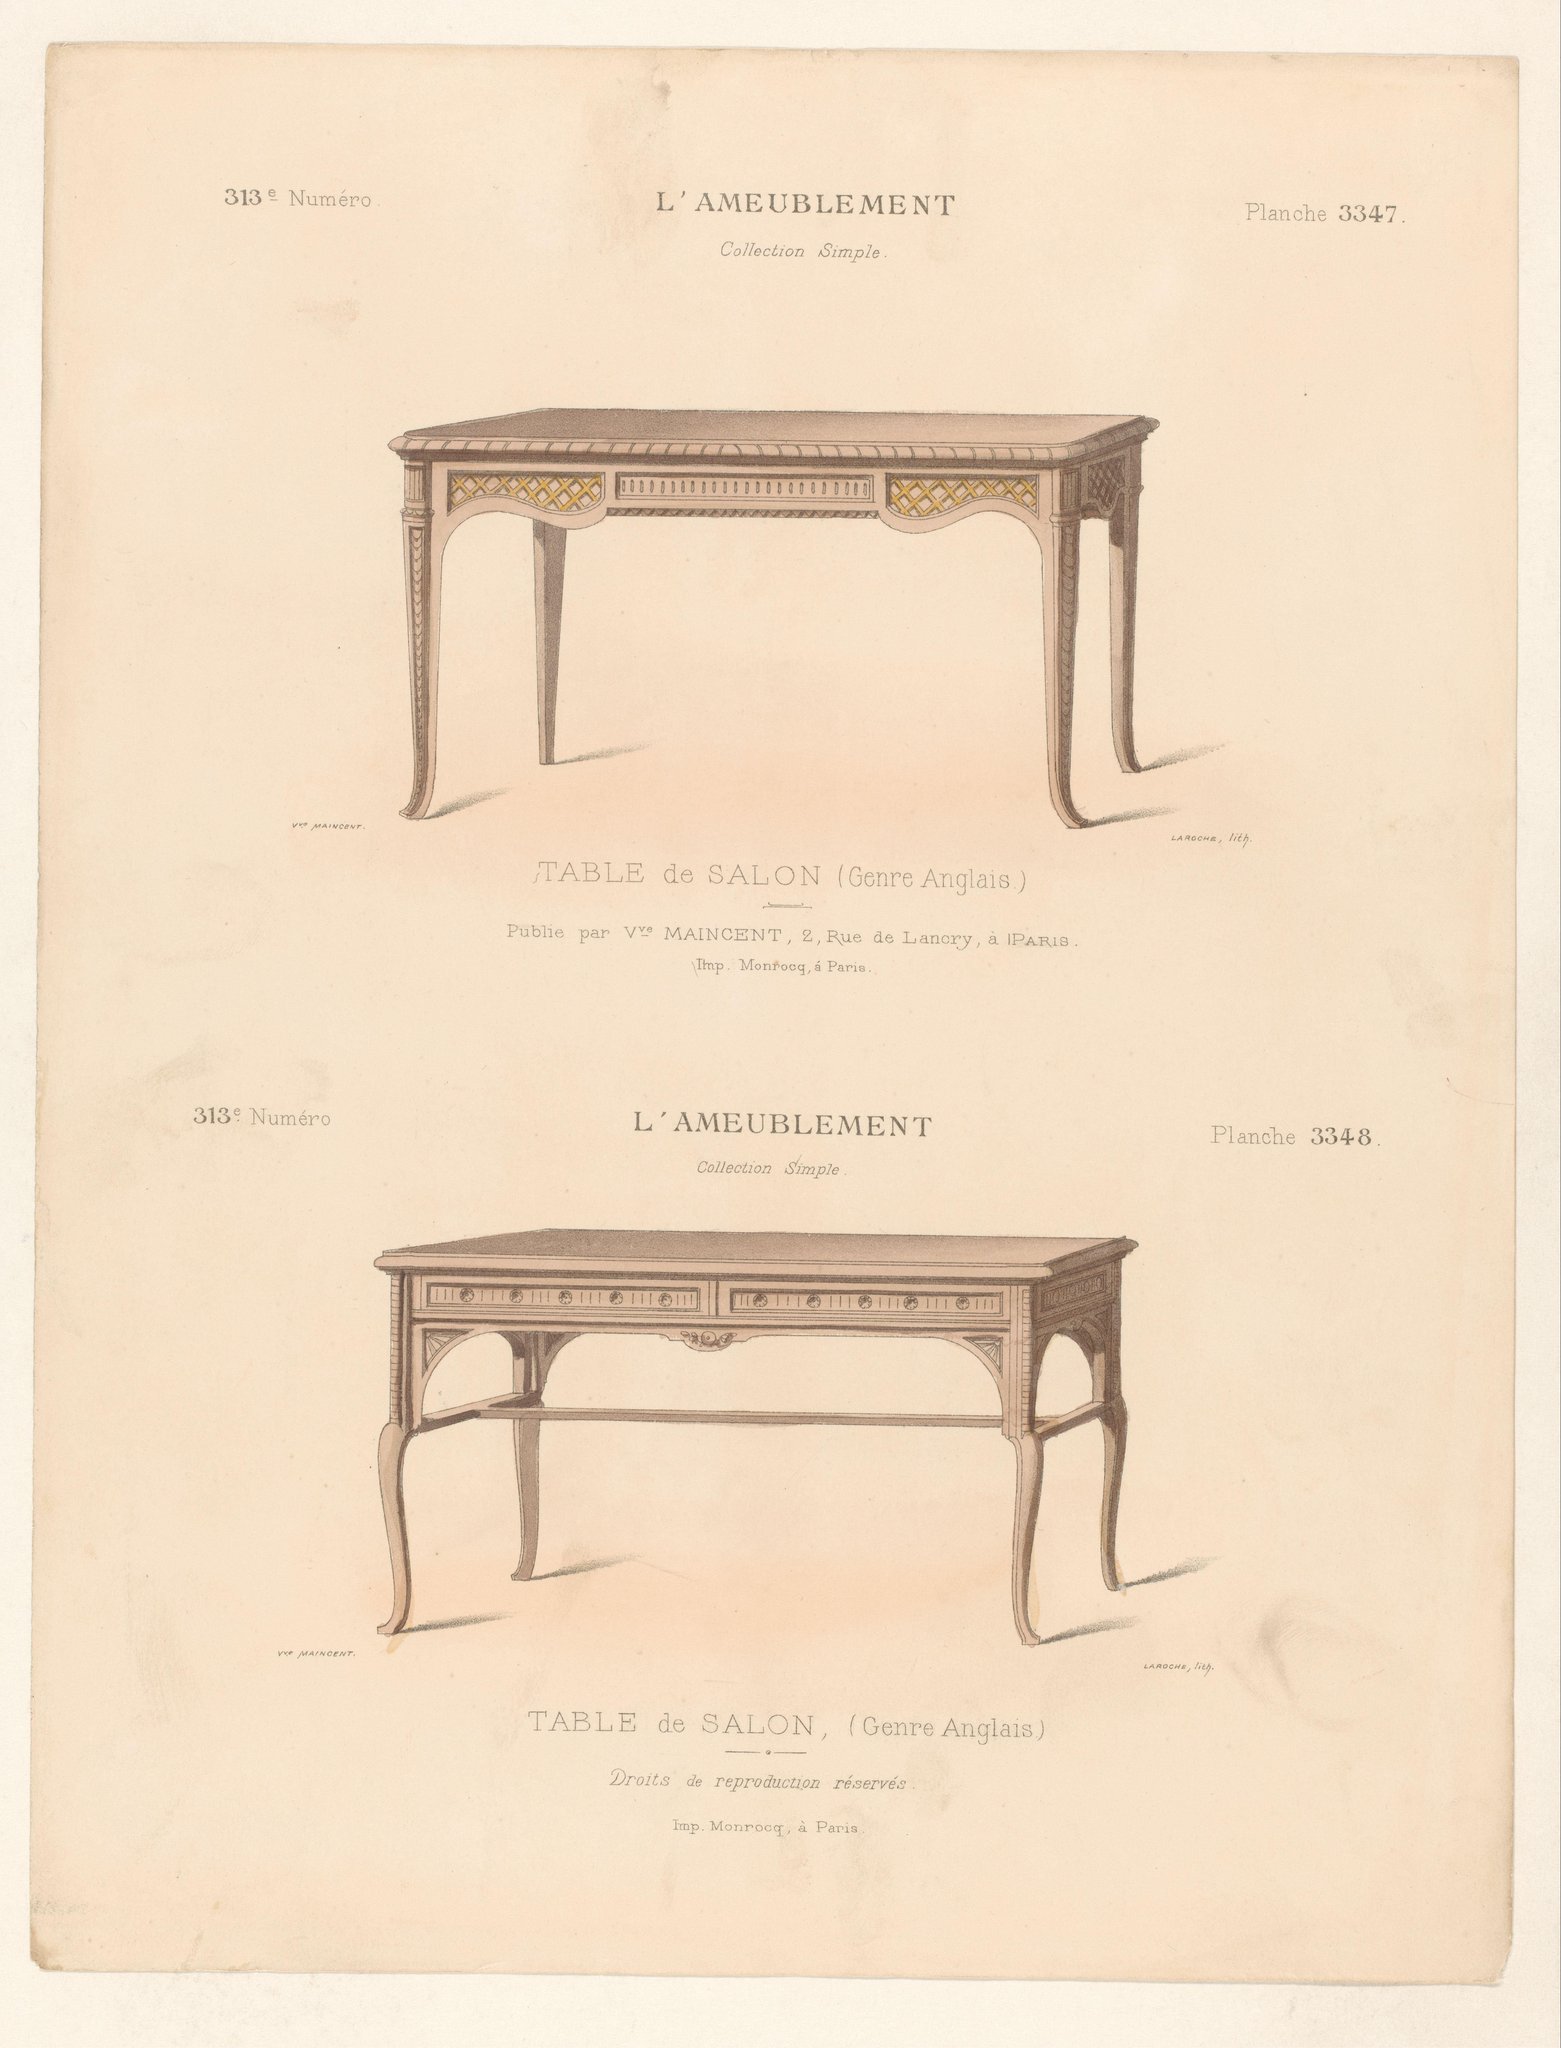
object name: print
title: Twee salontafels in Engelse stijl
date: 1895-1910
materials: paper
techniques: hand coloring, lithograph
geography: paris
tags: table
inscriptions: : ‘Droits de reproduction réservés.’